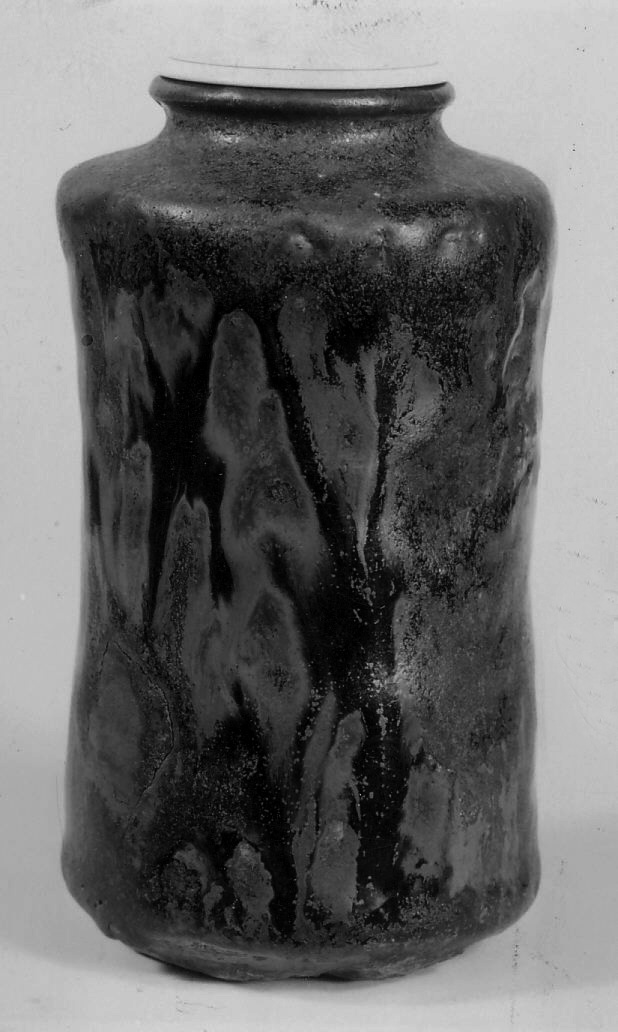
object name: tea jar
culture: japanese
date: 1601-1700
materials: clay, glaze